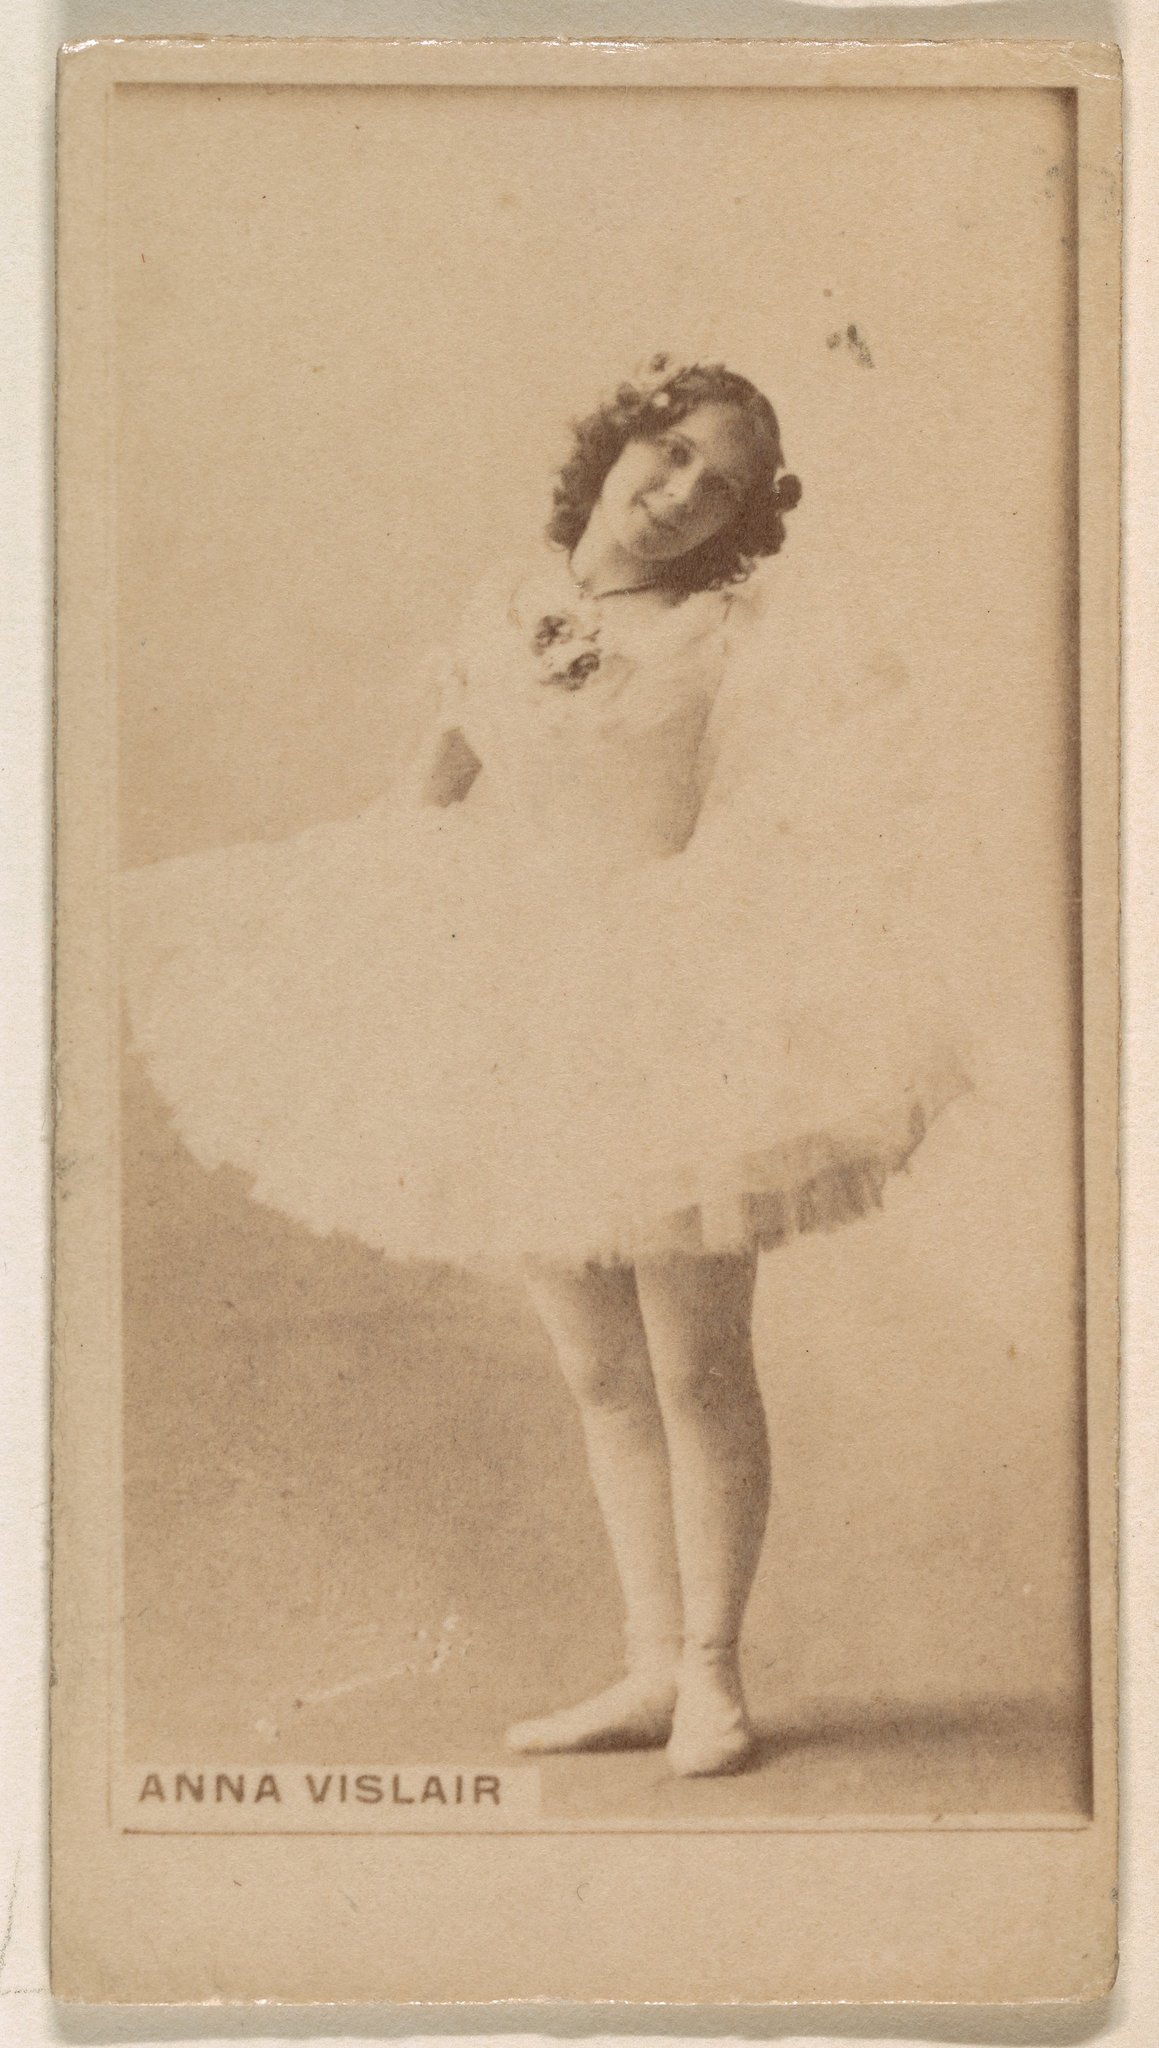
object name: photograph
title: Anna Vislair, from the Actresses series (N245) issued by Kinney Brothers to promote Sweet Caporal Cigarettes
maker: kinney brothers tobacco company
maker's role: publisher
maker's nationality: american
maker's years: 1869-2011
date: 1890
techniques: albumen silver print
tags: portraits,women